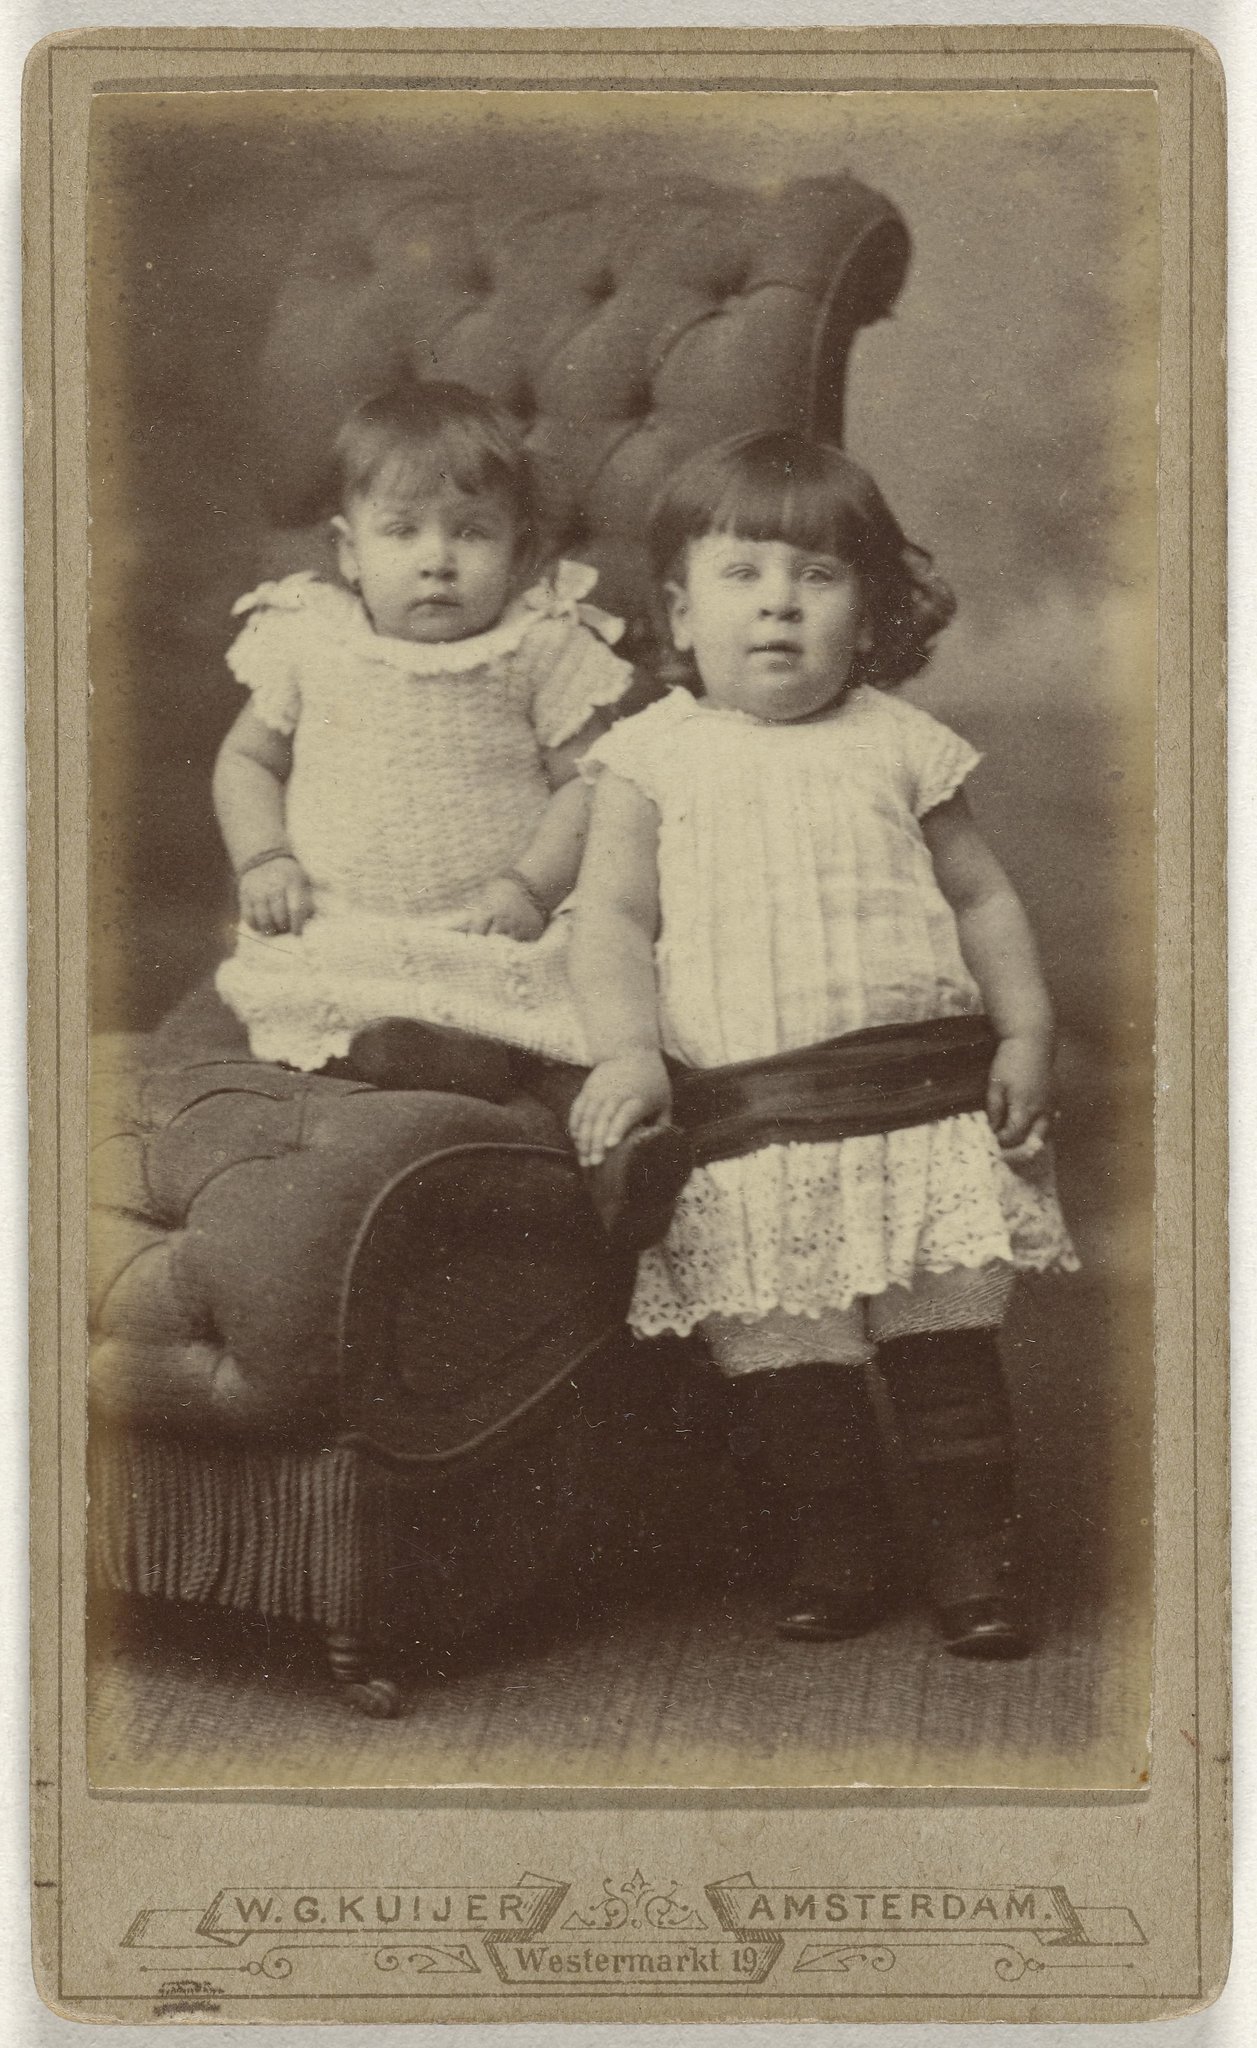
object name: photograph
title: Studioportret twee kleine kinderen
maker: willem gerhardus kuijer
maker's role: fotograaf, hoffotograaf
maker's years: 1834-1899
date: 1908-1915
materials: photographic support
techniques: albumen print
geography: amsterdam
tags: amsterdam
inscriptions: name: ‘Photographie instantanee W.G. Kuijer Westermarkt 19 Amsterdam’